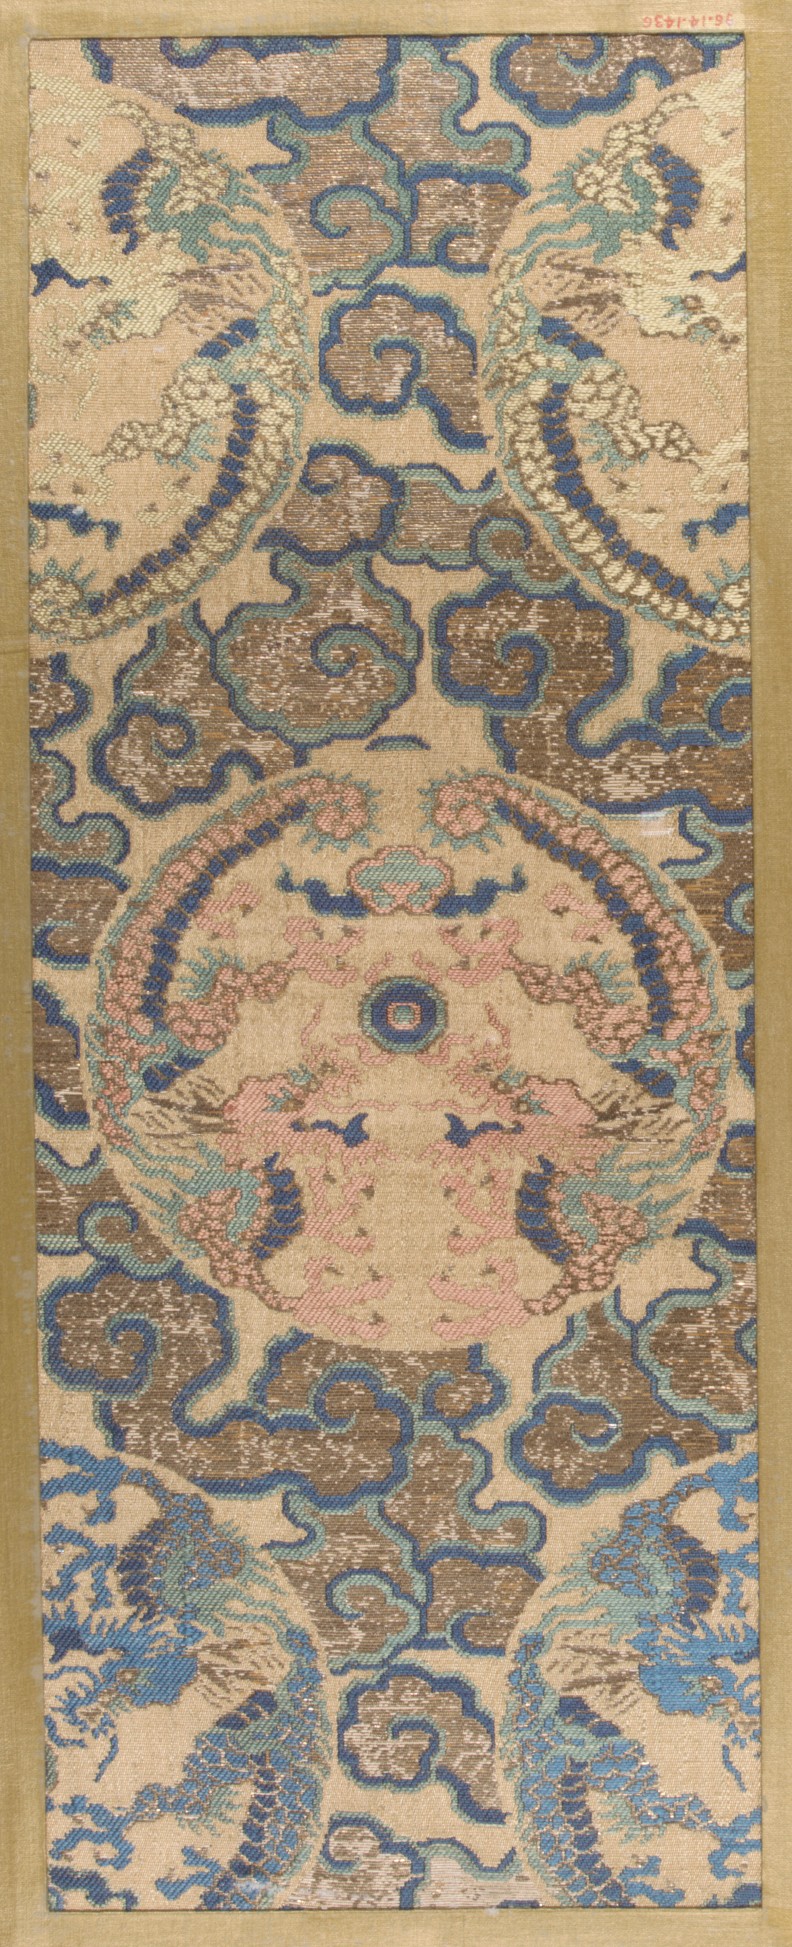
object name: piece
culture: japanese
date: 1701-1900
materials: silk